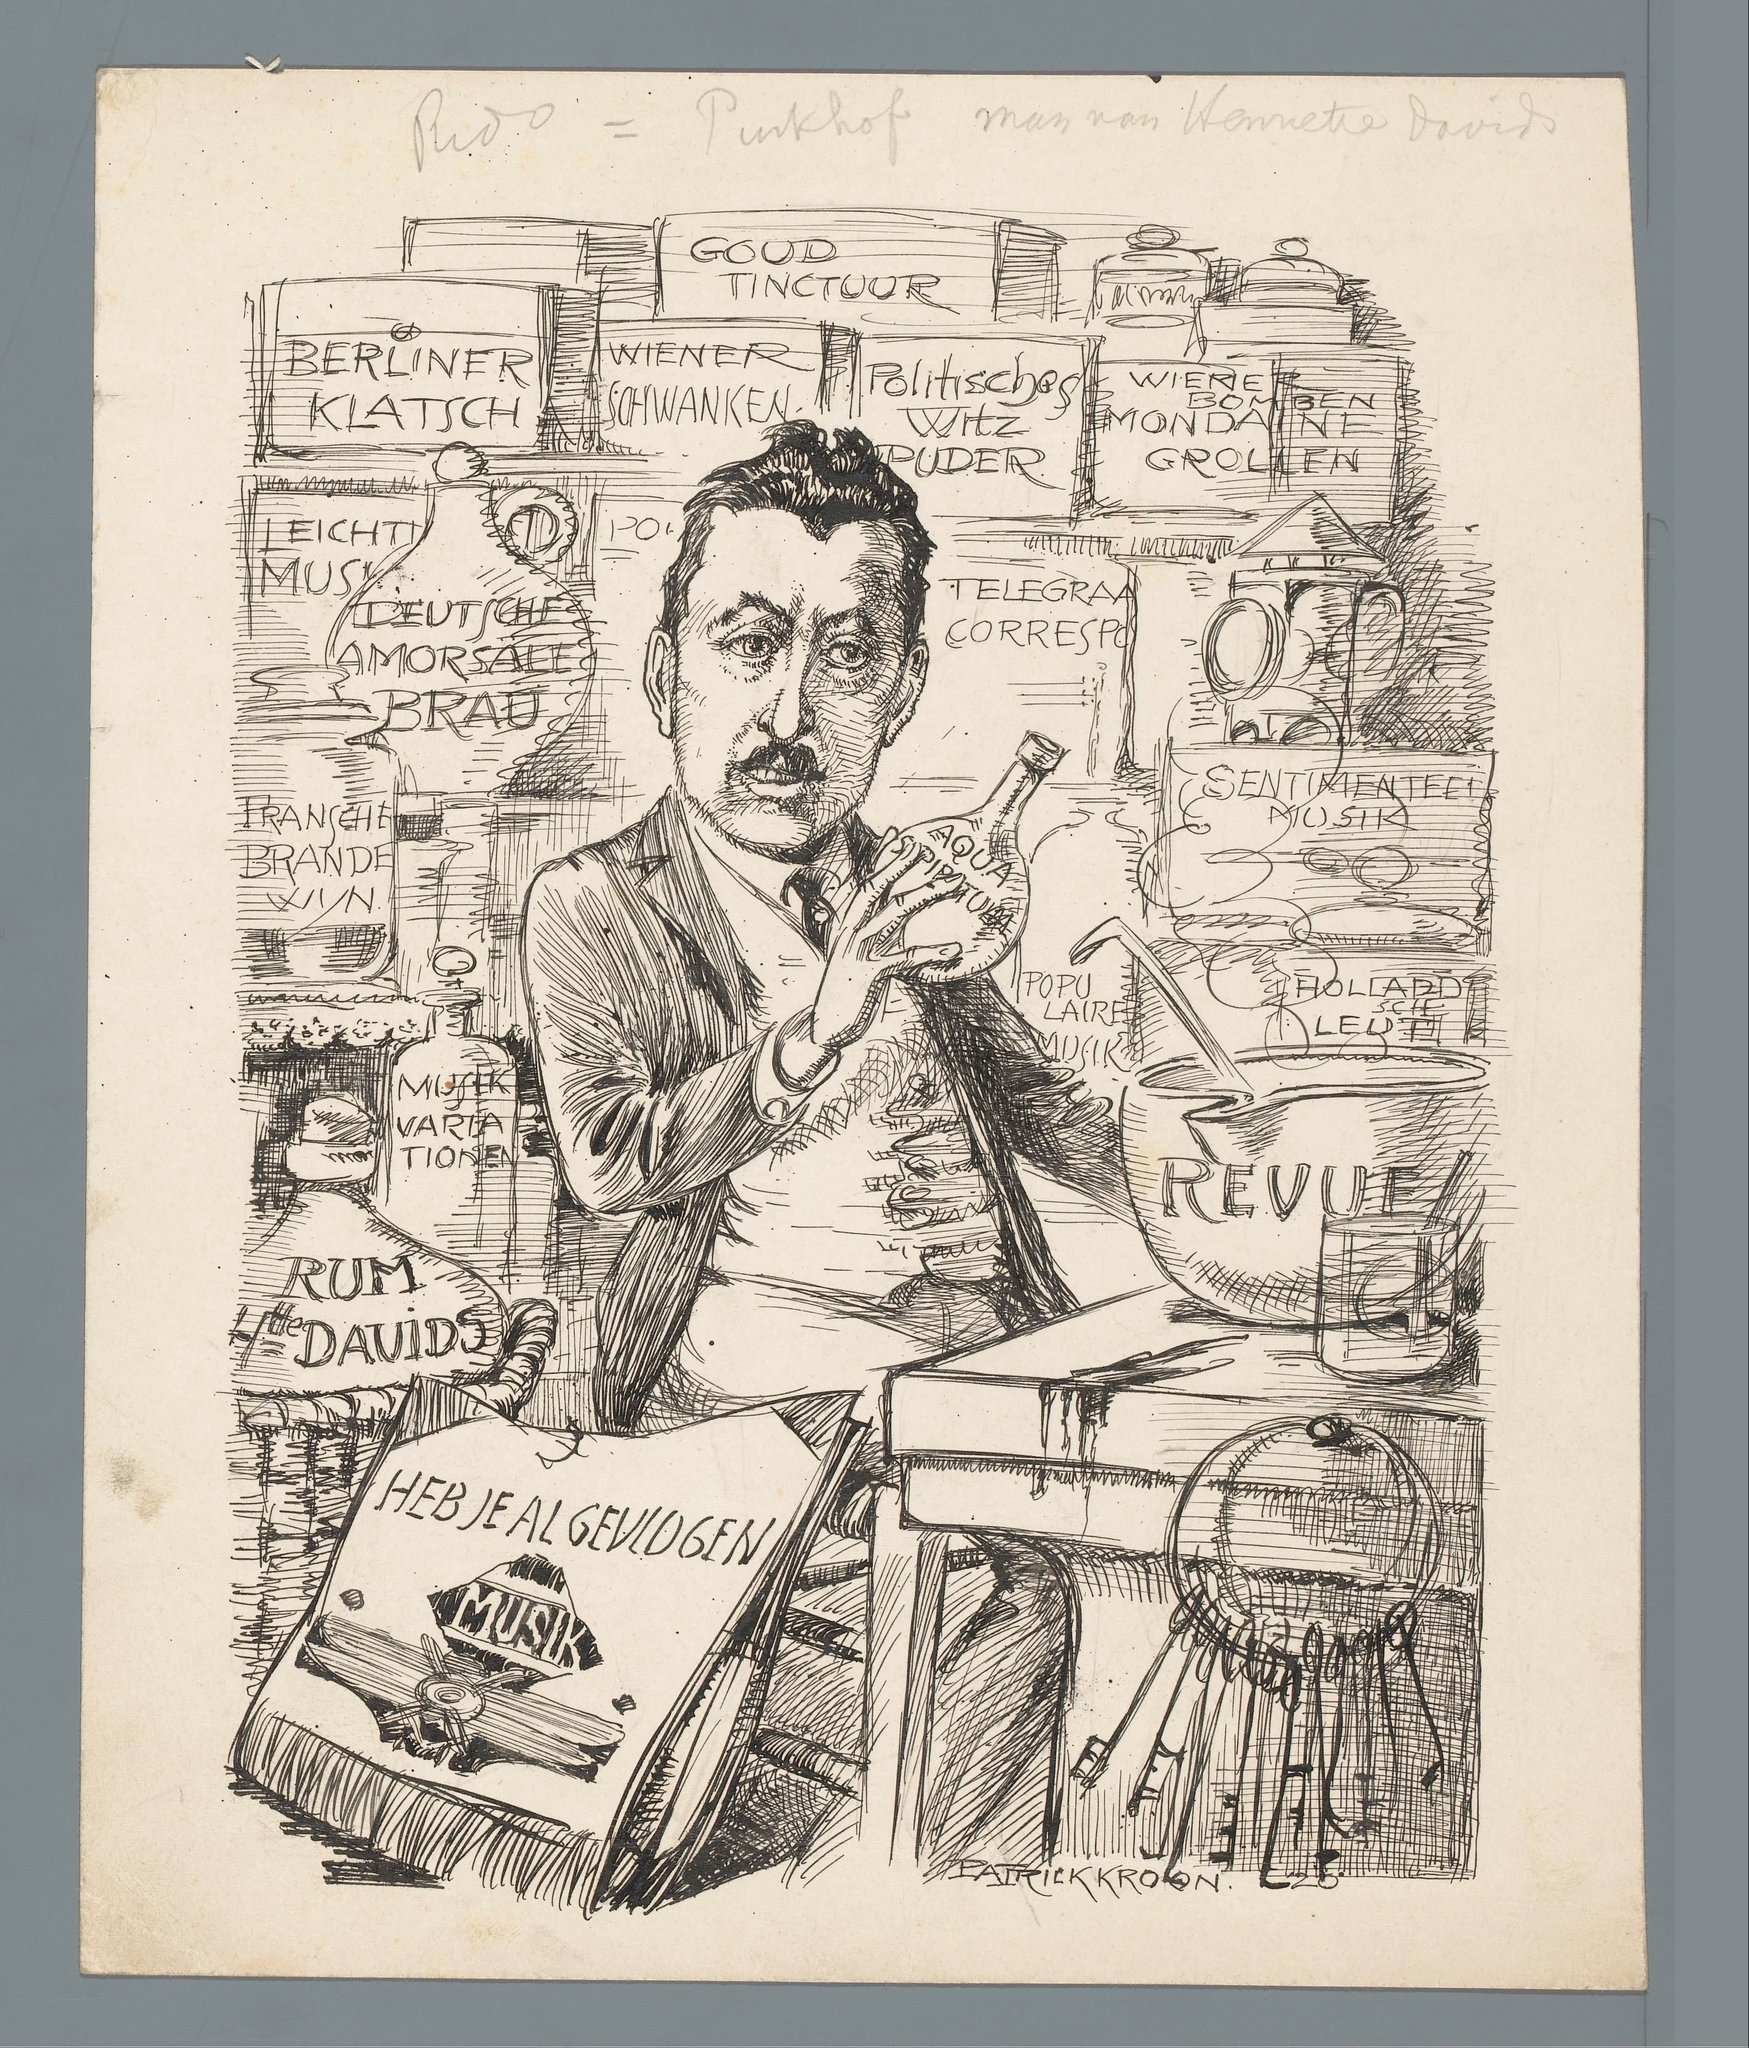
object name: cartoon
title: Philip Pinkhof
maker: patricq kroon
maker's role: draughtsman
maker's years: 1862-1941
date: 1920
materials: ink, paper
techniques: pen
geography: netherlands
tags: the hague, pharmacist, druggist, apothecary; pharmacy, drugstore, dispensing chemist, political caricatures and satires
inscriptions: inscription: ‘Pinkhof man van Henriette Davids’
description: Philip Pinkhof, de man van Henriëtte (Heintje) Davids, als apotheker omgeven door dozen, potten en flessen met allerlei middeltjes. Op de voorgrond een map met muziek. Ontwerp voor een cartoon in de krant in 1920.